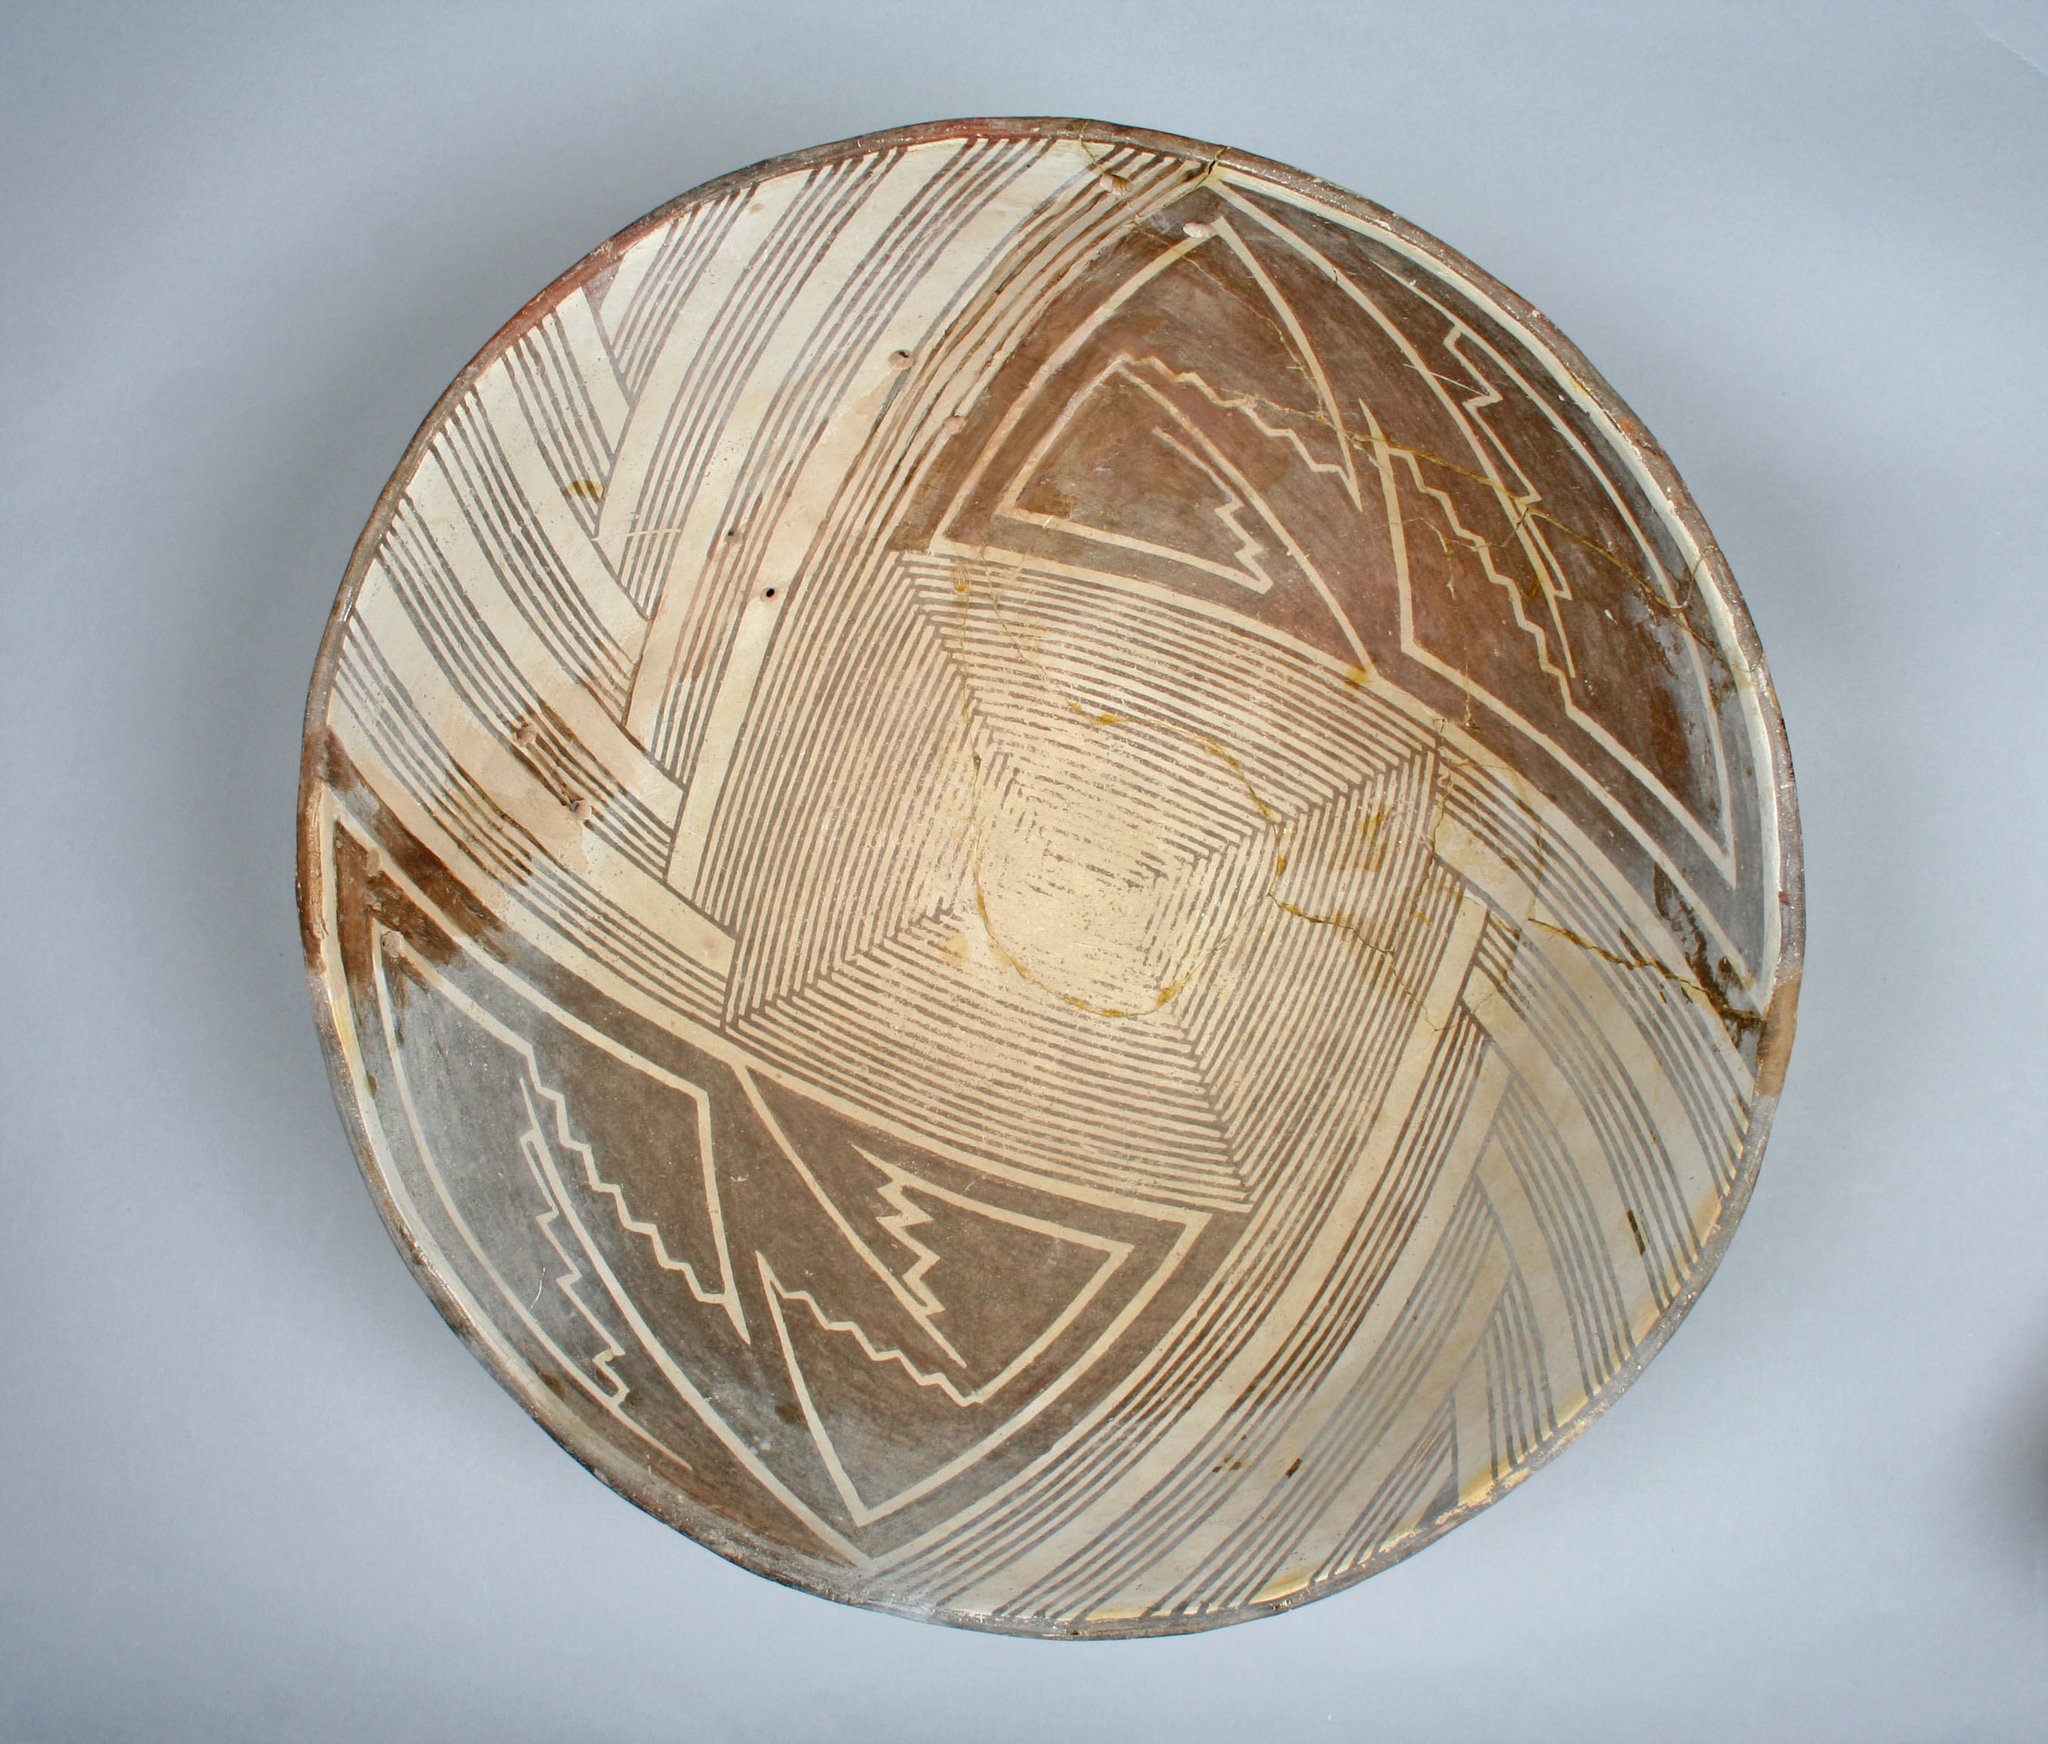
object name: bowl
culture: mimbres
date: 701-1000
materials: ceramic, pigment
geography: united states